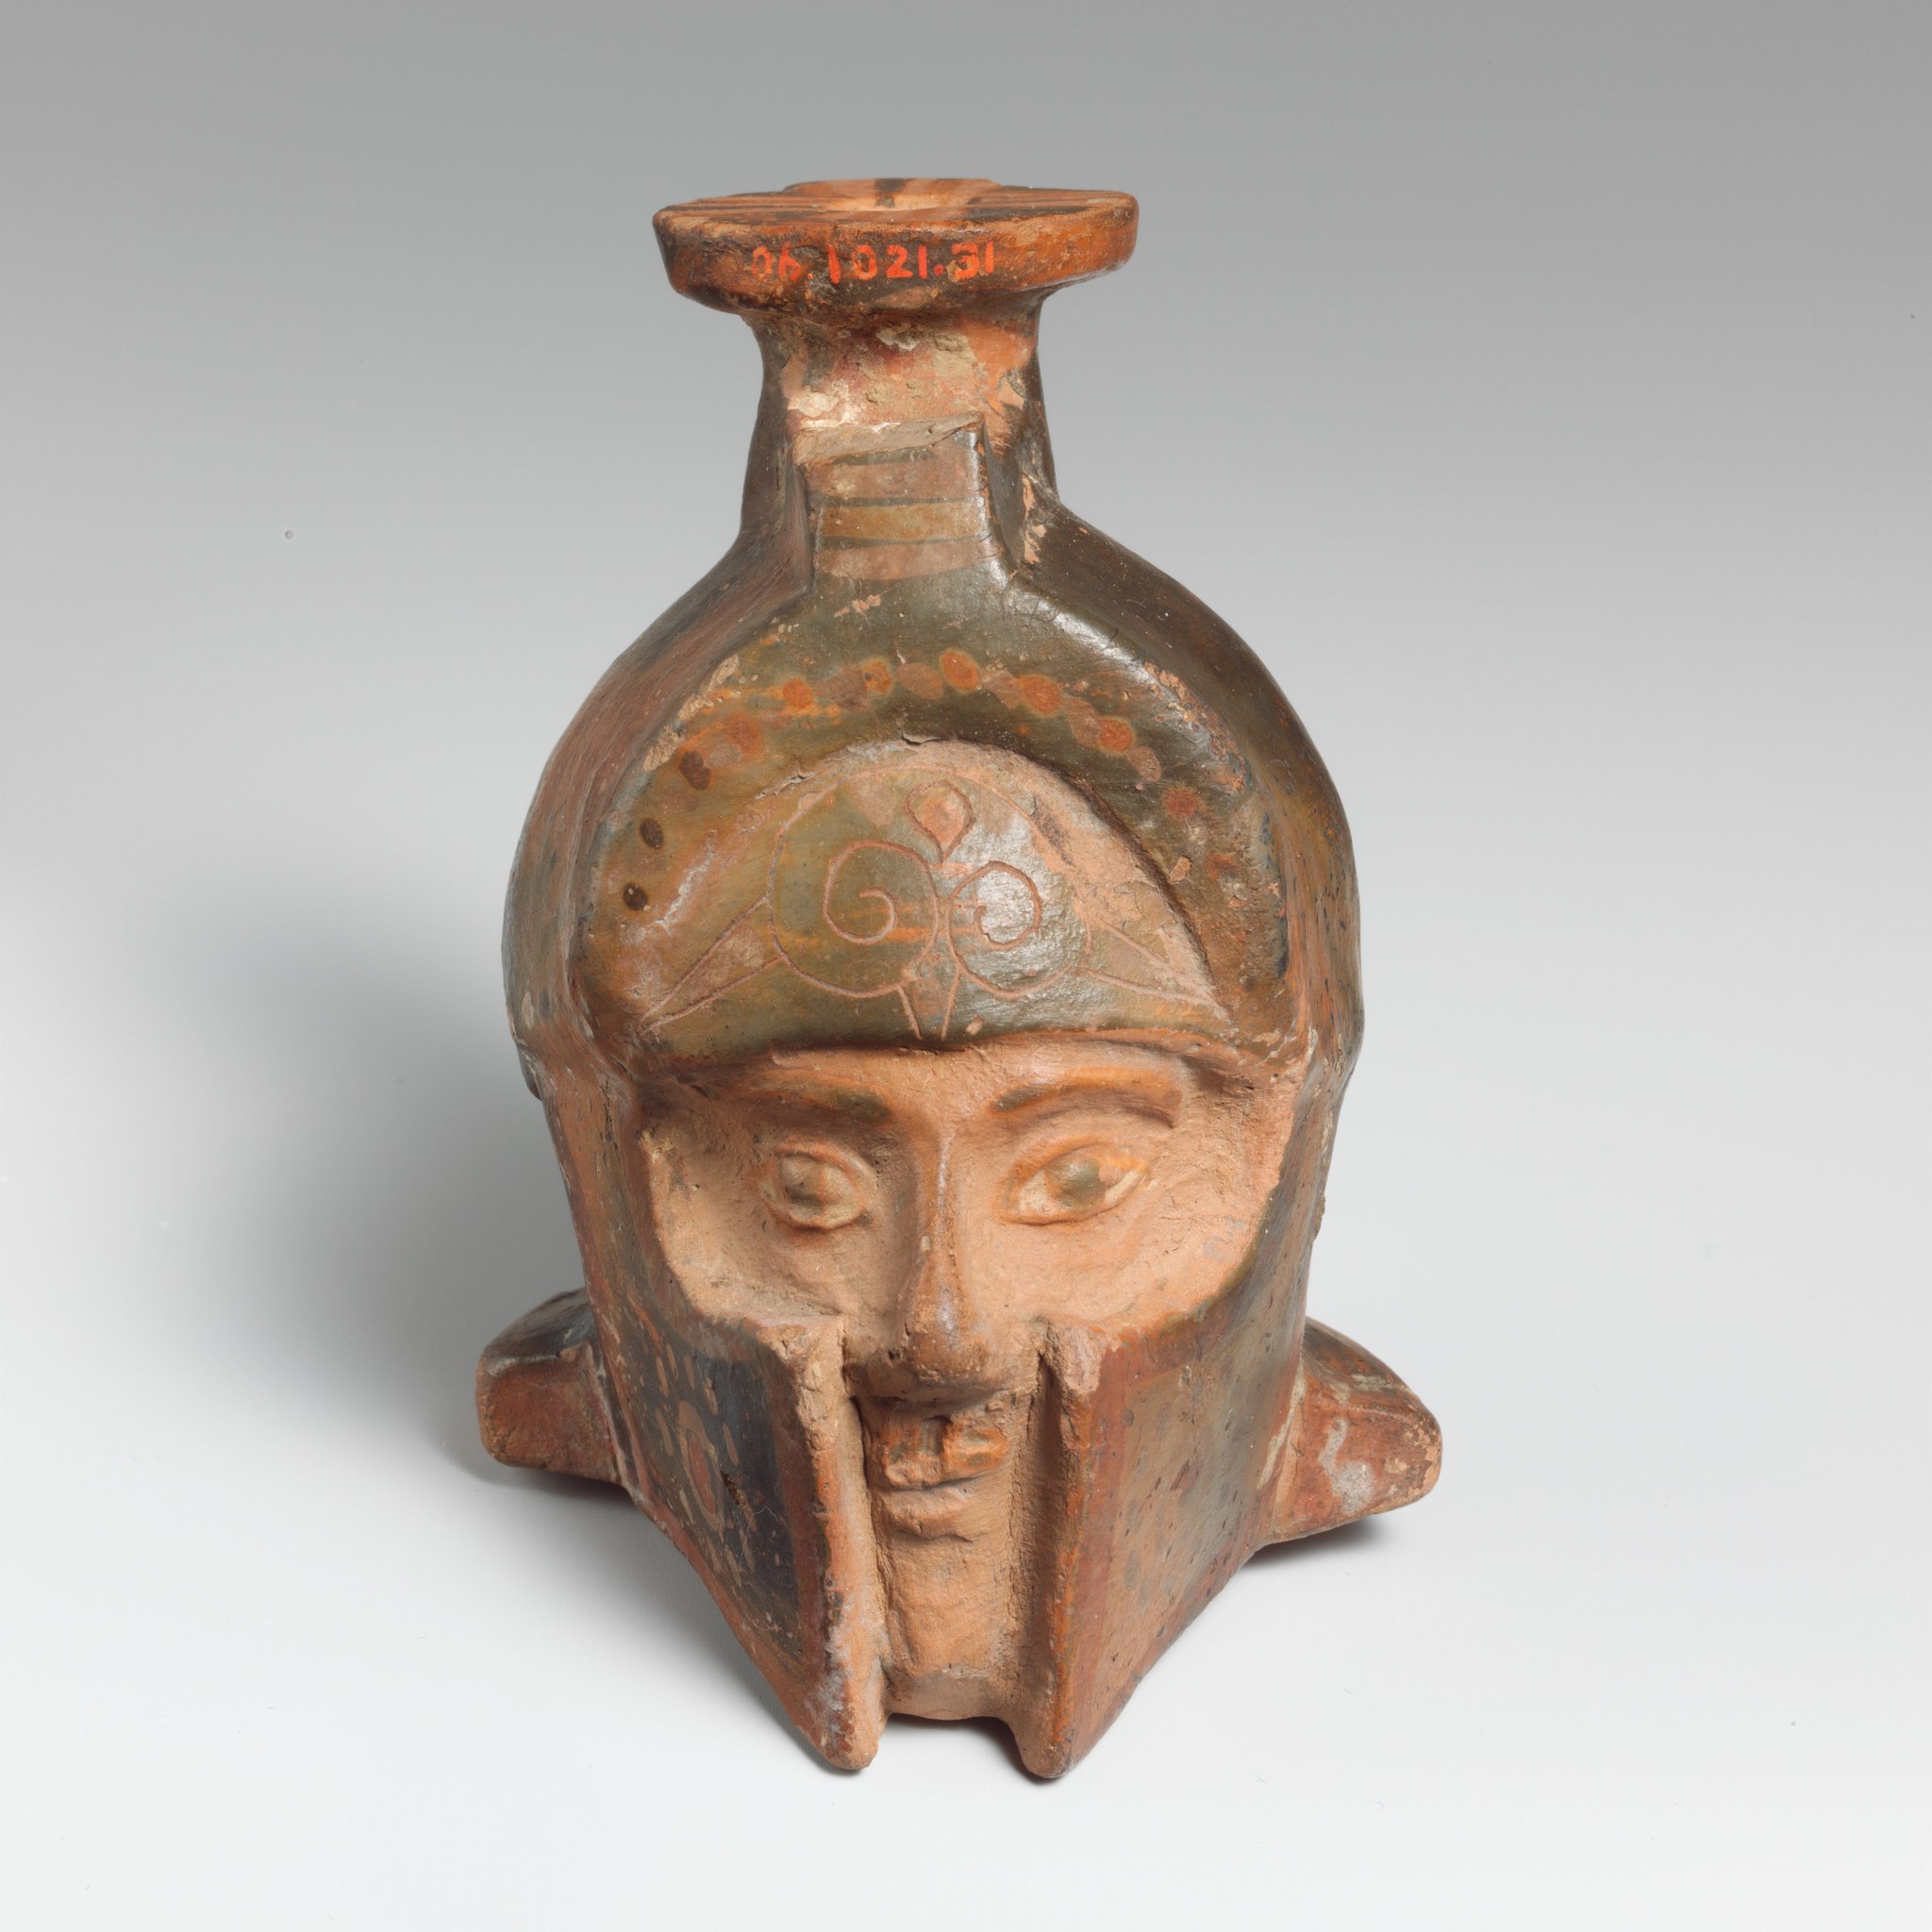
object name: aryballos in the form of a helmeted head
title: Aryballos (perfume flask) in the form of a helmeted head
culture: east greek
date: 600-501 BCE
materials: terracotta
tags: helmets,heads